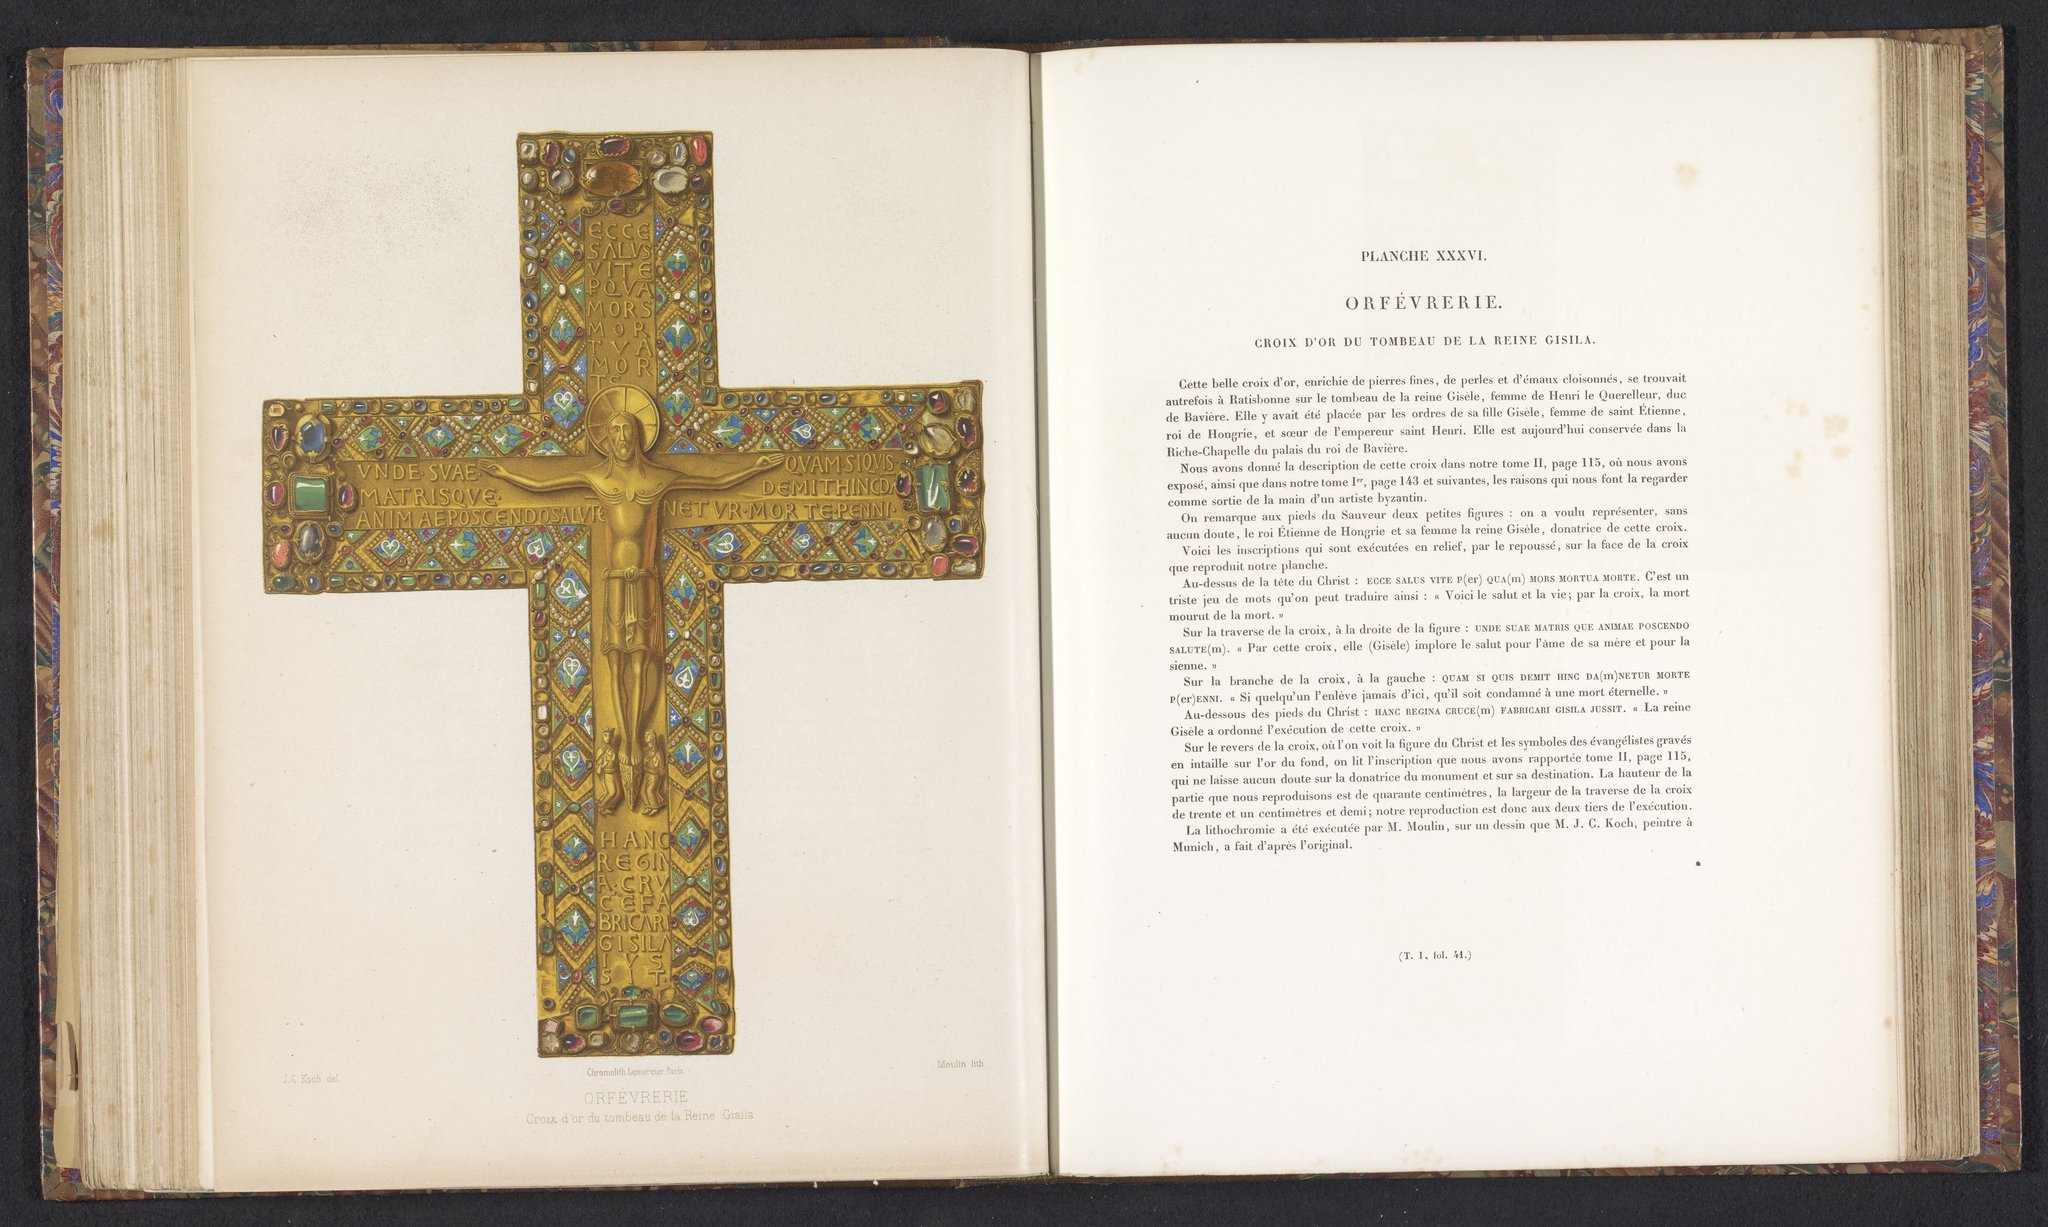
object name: print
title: Croix d'or du tombeau de la Reine Gisila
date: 1859-1864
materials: paper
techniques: chromolithography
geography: paris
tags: the cross ~ symbols of christ